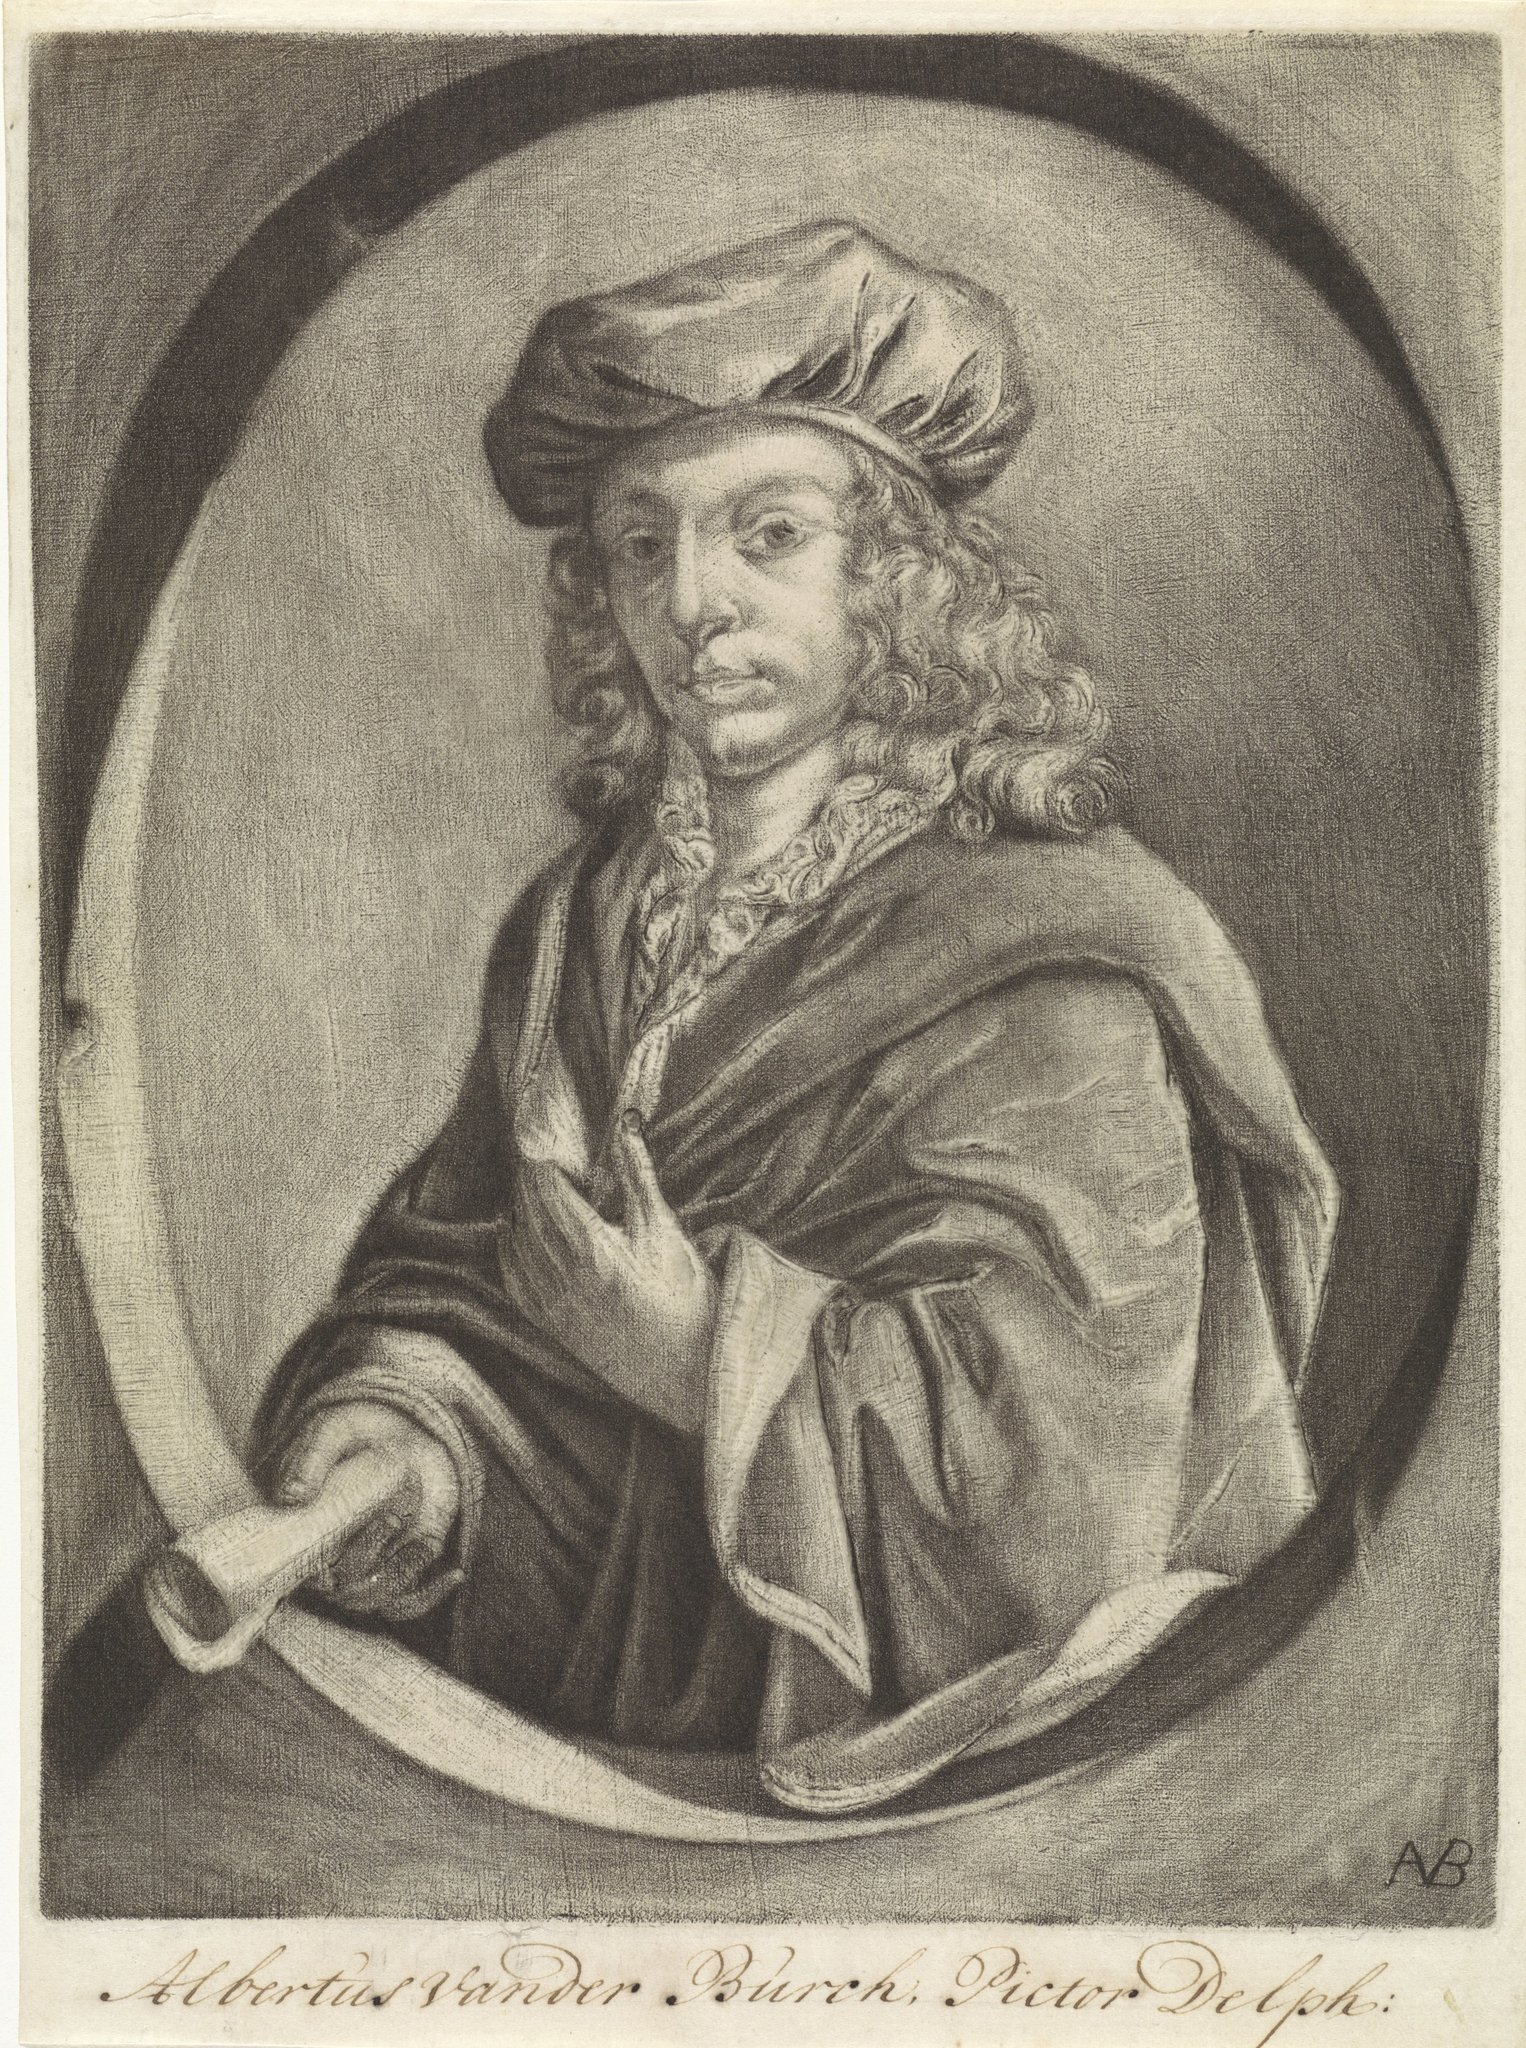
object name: print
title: Zelfportret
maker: albertus van der burch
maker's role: print maker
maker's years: 1672-1729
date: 1687-1750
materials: paper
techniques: pen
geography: delft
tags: print maker, albertus van der burch, letter, envelope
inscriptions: inscription: ‘Albertus van der Burch, Pictor Delph:’, collector's mark: Lugt 2228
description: Zelfportret van de schilder Albertus van der Burch, met in de hand een rol papier.